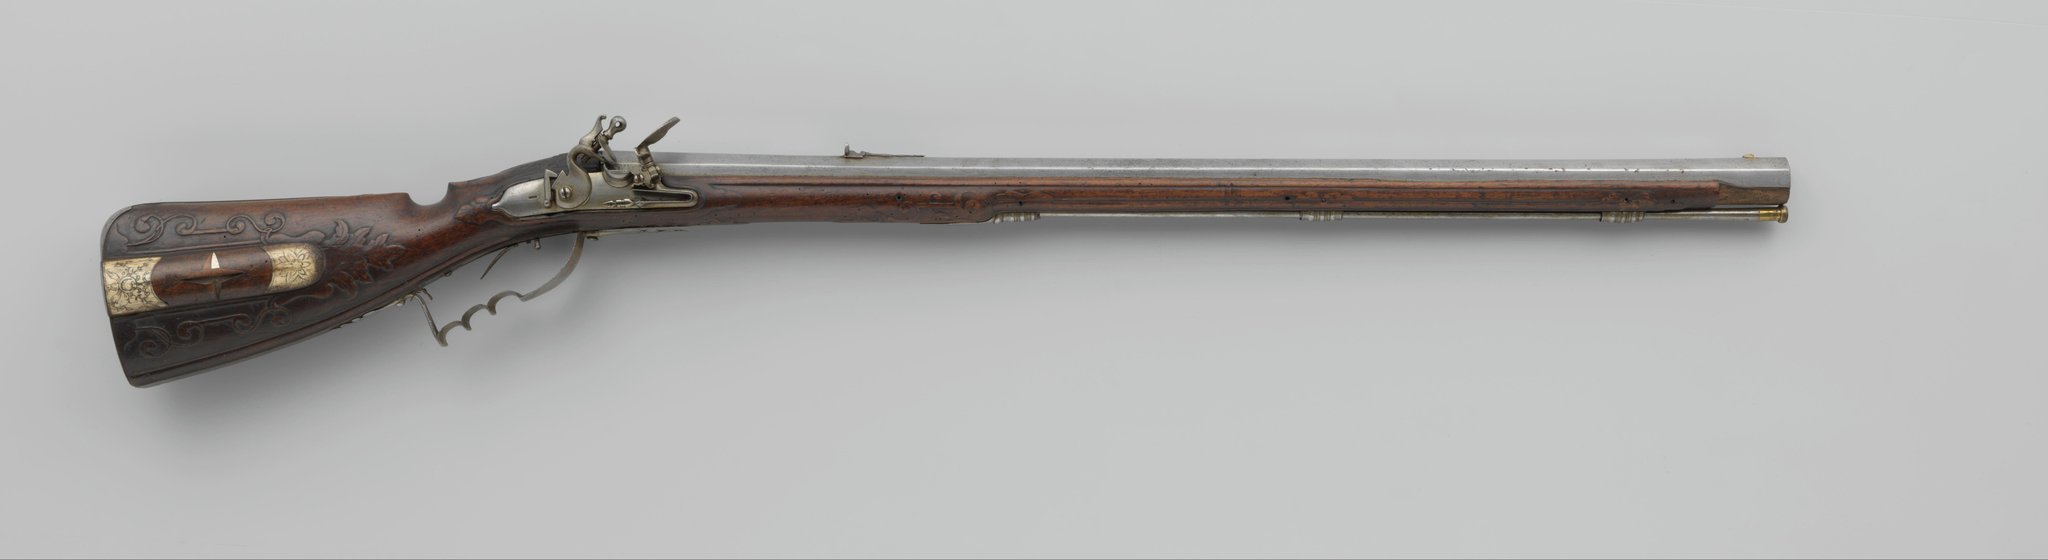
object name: flintlock pistol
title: Vuursteengeweer met batterijslot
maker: Anonymous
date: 1599-1799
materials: iron, wood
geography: europe